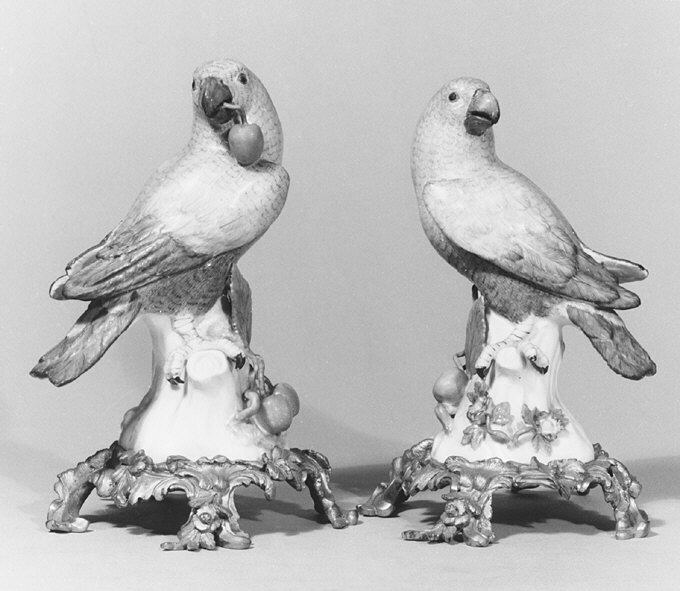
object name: figure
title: Parrot (one of a pair)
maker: meissen manufactory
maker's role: manufactory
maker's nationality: german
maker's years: 1710-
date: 1741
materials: gilt bronze, hard paste porcelain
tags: fruit,parrots,flowers,leaves